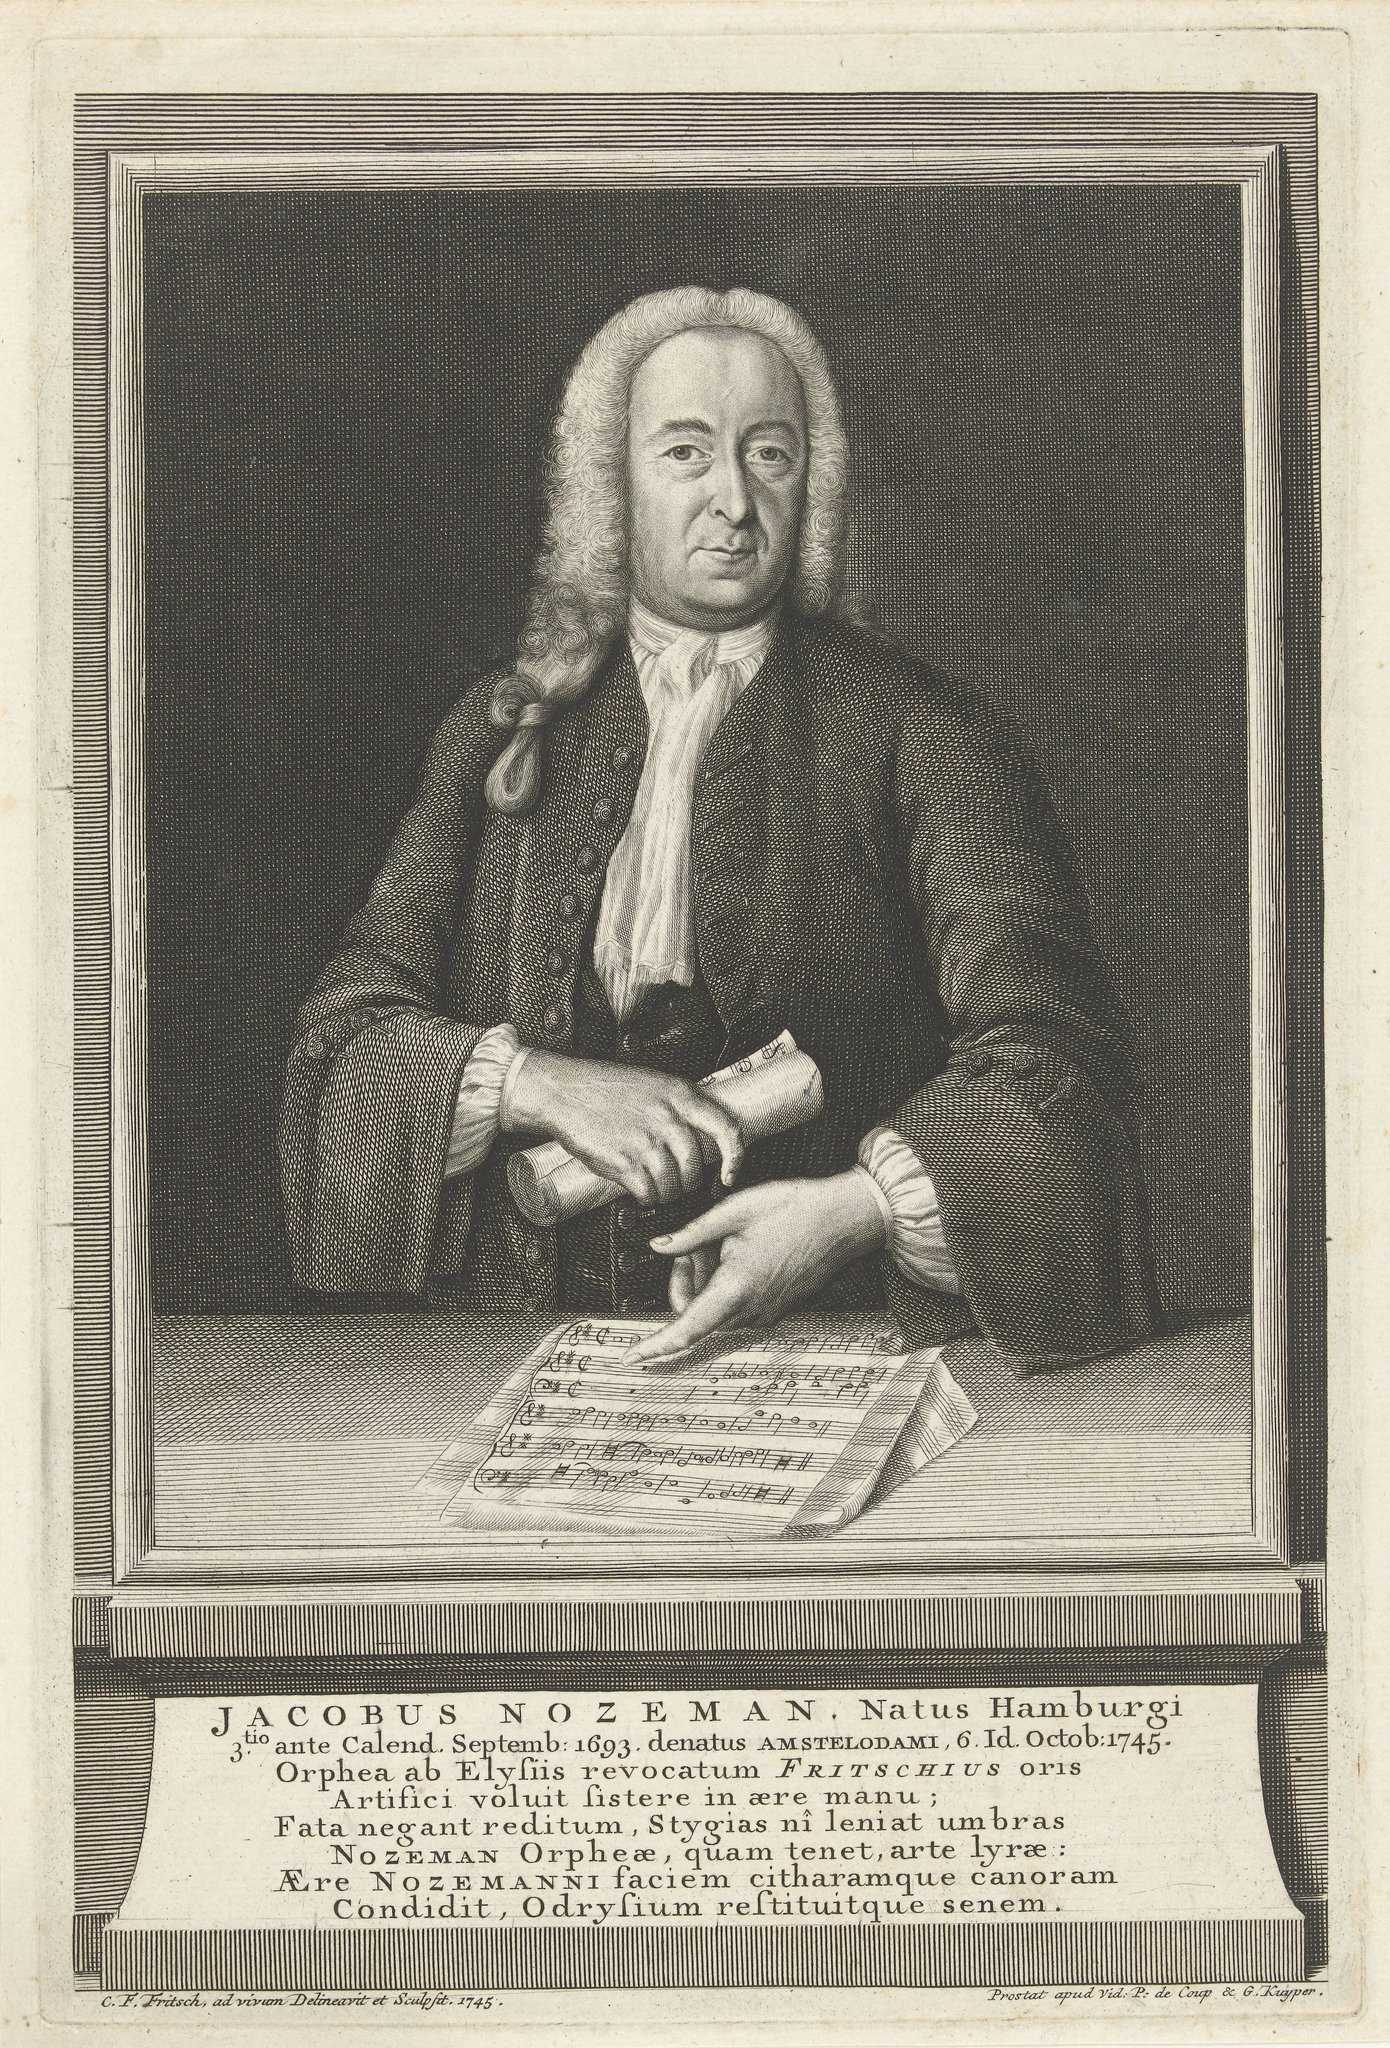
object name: print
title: Portret van Jacobus Nozeman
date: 1745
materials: paper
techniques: engraving, etching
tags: amsterdam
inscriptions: collector's mark: Lugt 2228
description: De componist Jacobus Nozeman,met pruik, wijzend op een muziekblad dat voor hem op tafel ligt. In zijn rechterhand houdt hij een rol papier. Onder het portret staan op een sokkel zijn naam, geboorte- en sterfdatum en een zesregelige tekst in het Latijn.